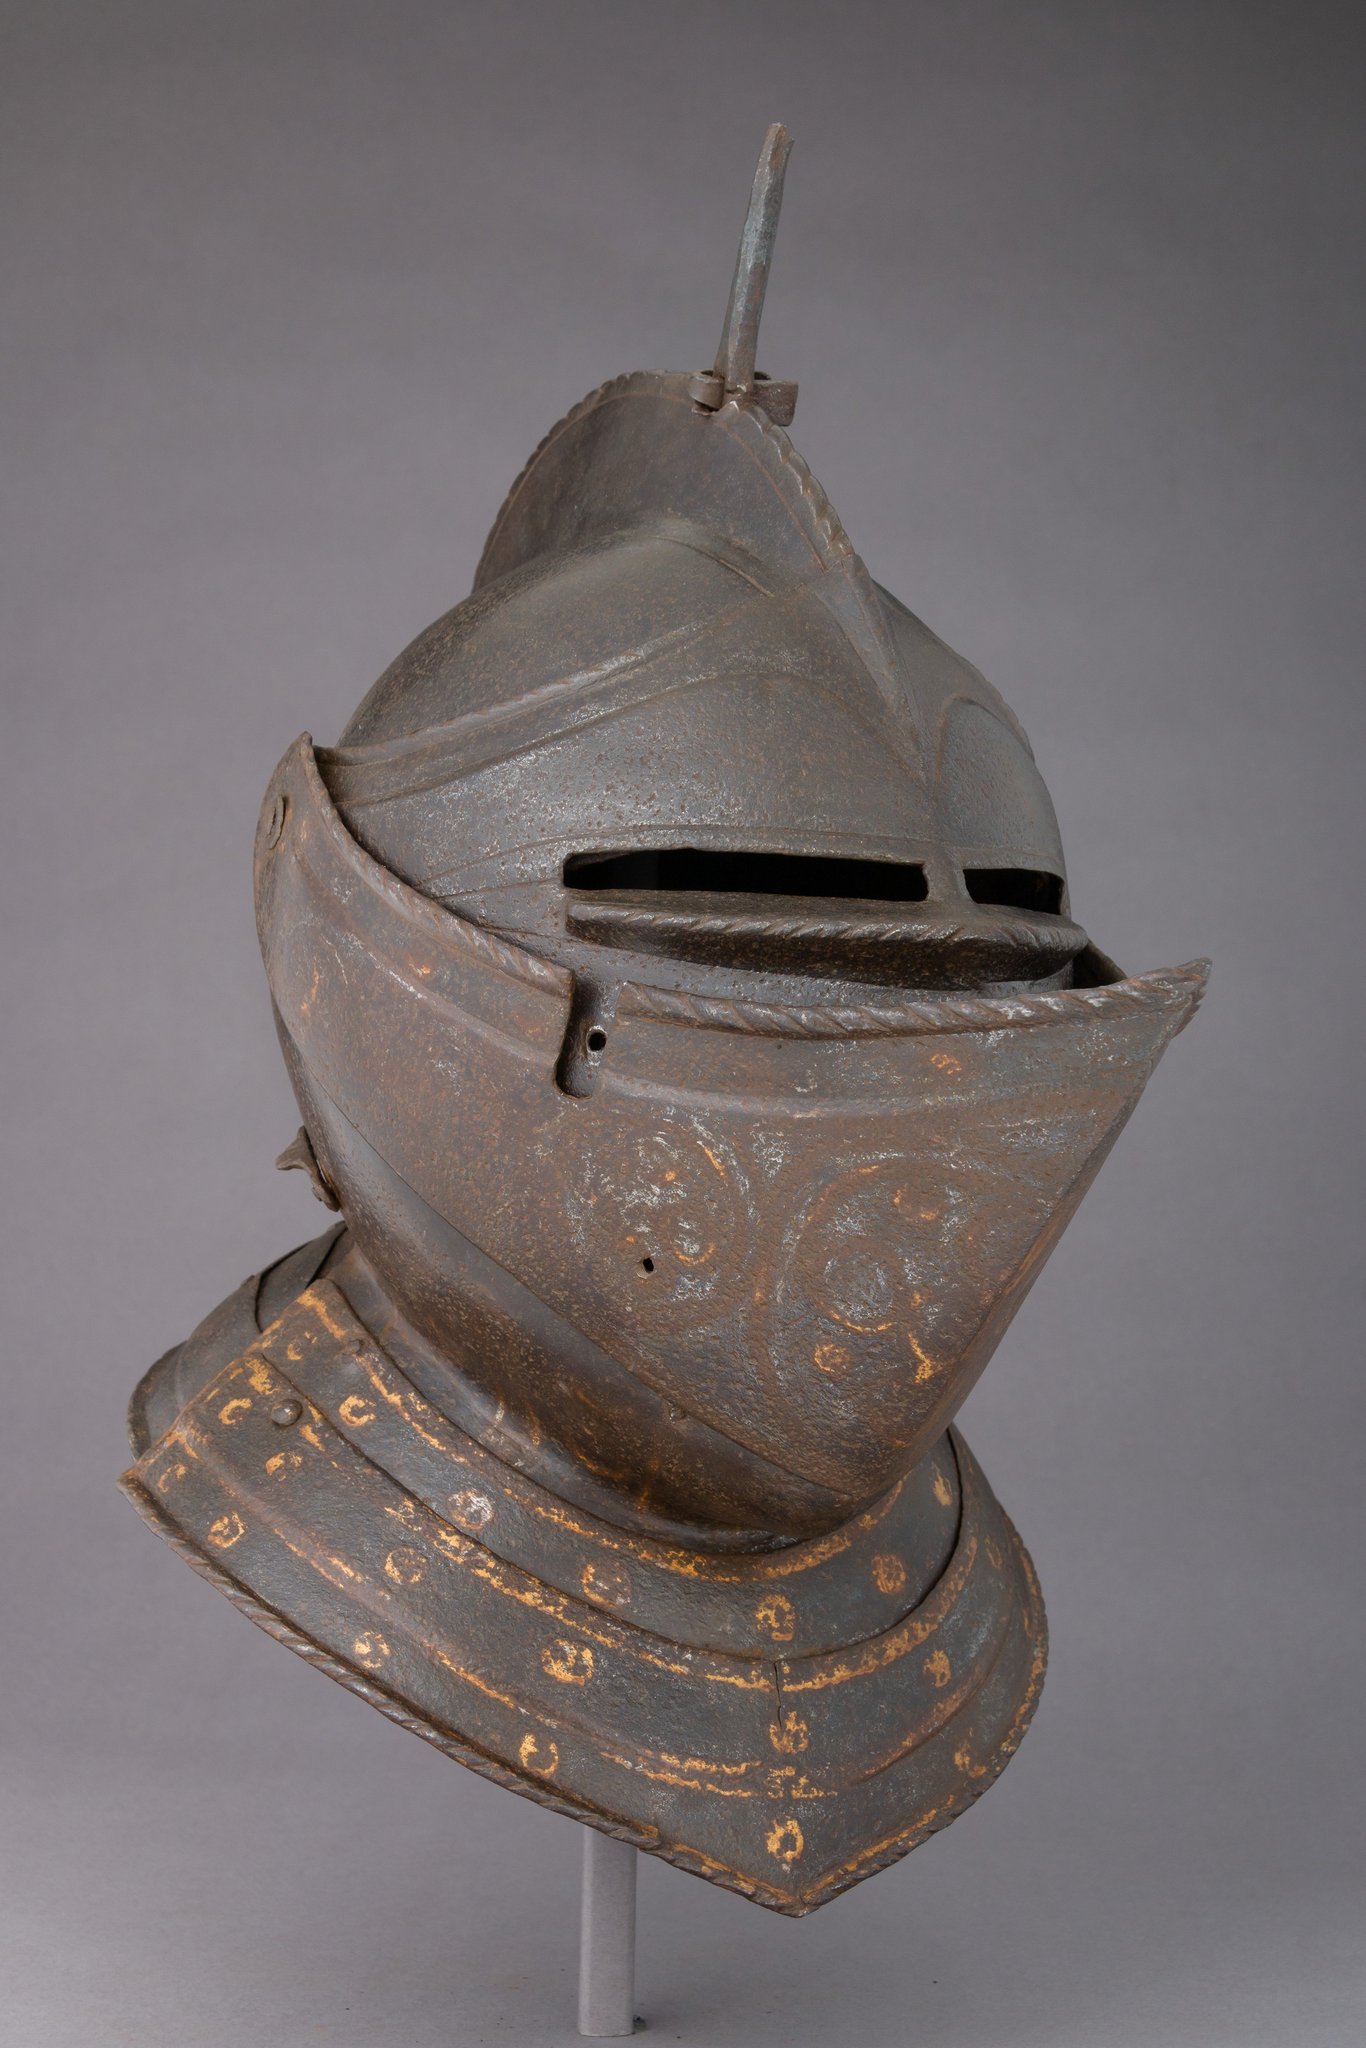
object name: close helmet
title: Close-Helmet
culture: british or flemish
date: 1560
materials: steel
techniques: polychromy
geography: england